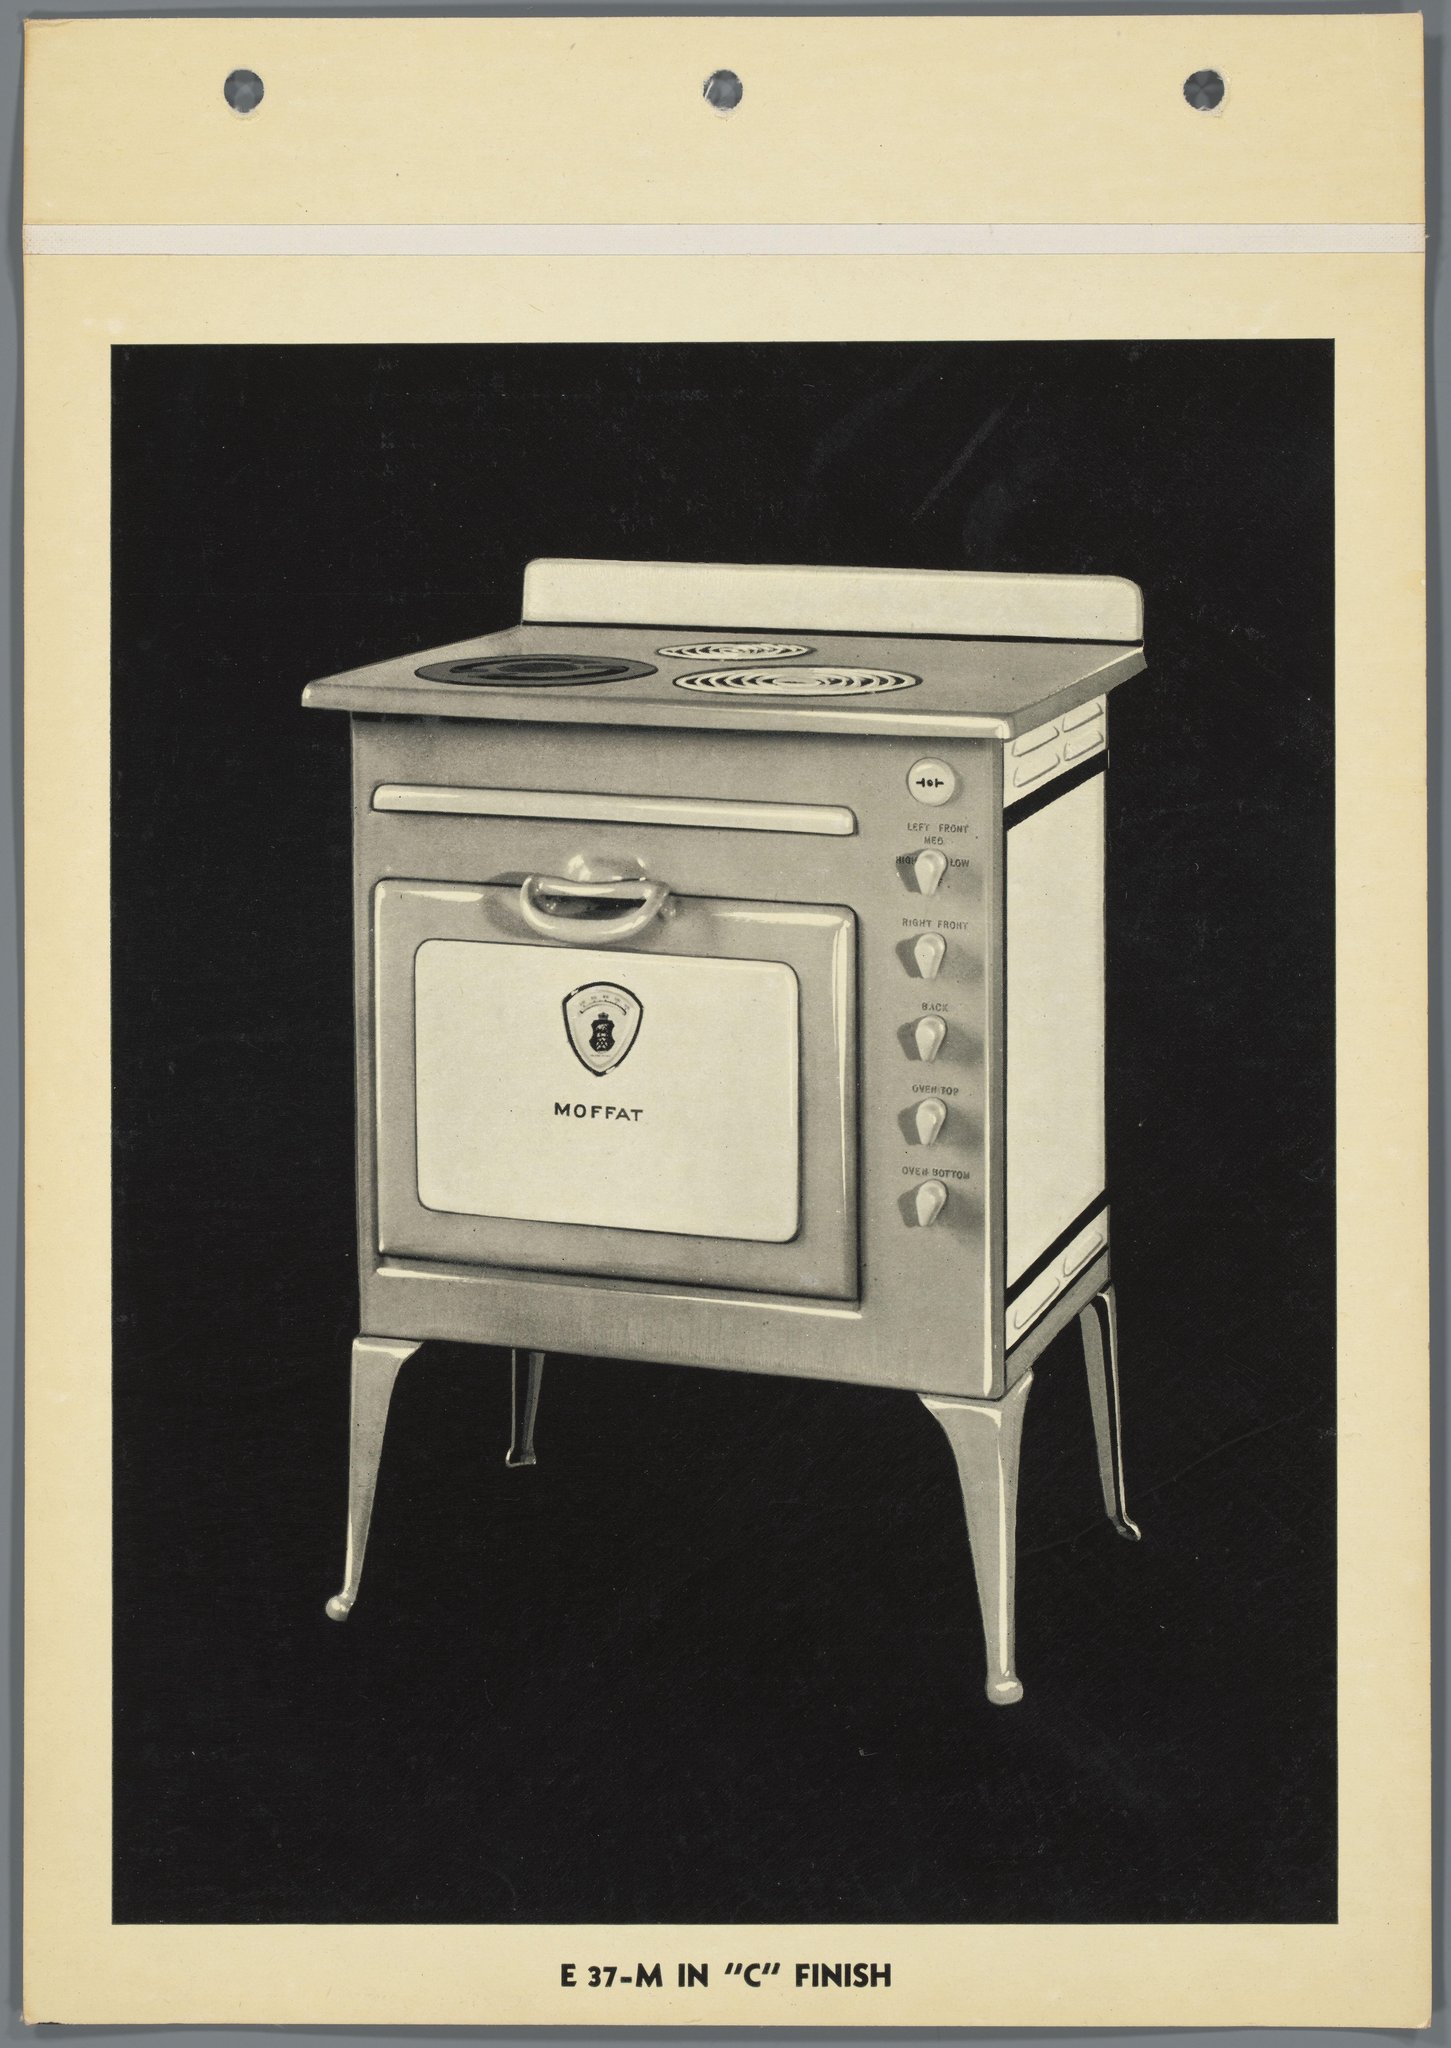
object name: photograph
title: Foto van Moffat ovens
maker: Anonymous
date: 1935-1940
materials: paper, textile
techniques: autotype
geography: canada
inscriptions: inscription: ‘E 37-M IN "C" FINISH’